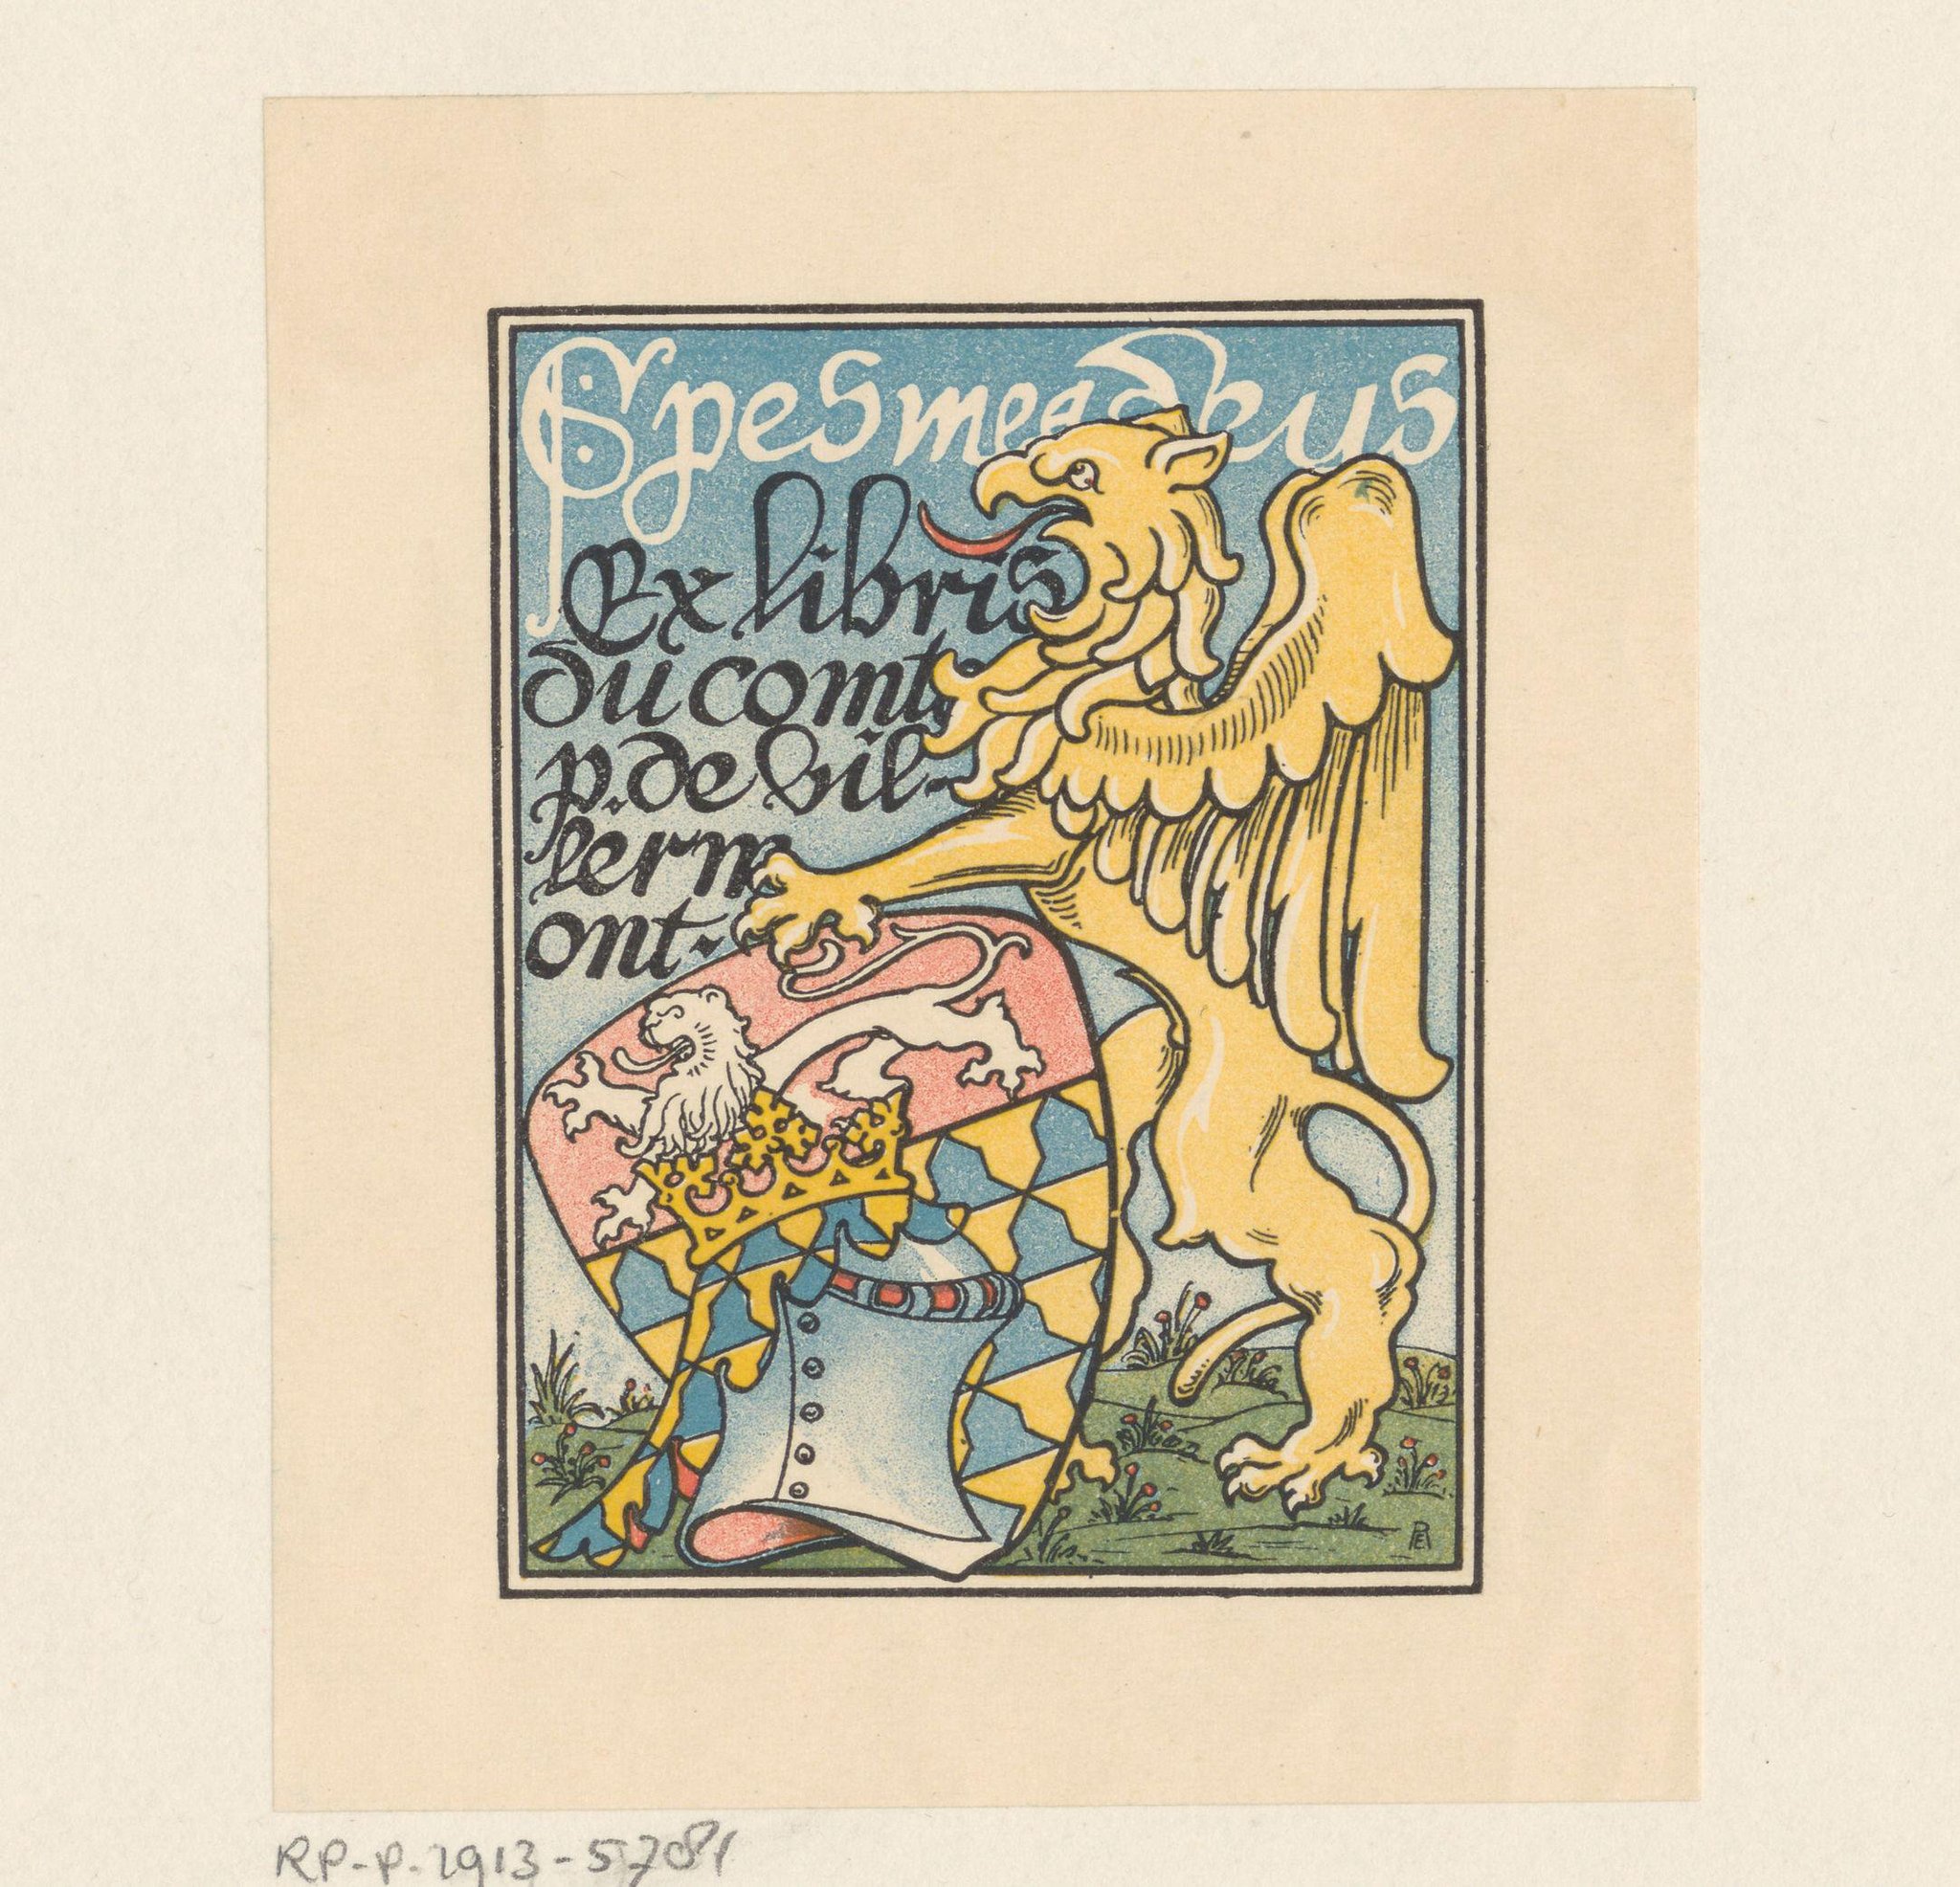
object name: bookplate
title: Ex libris van P. de Billermont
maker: Anonymous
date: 1880-1913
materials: paper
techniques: lithograph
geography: france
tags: griffin (lion/eagle); 'griffo' (ripa), armorial bearing, heraldry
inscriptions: collector's mark: Lugt 2233, collector's mark: Lugt 2760